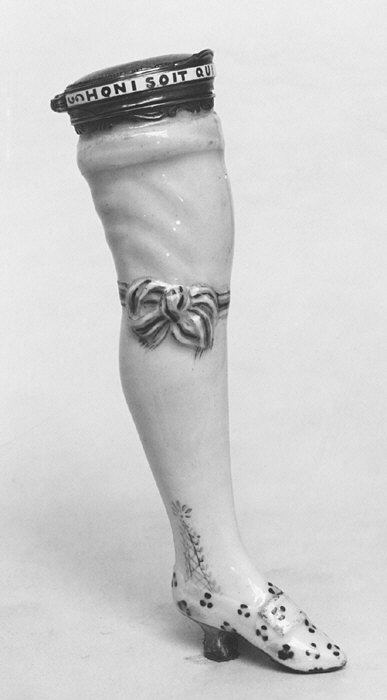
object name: needle case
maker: meissen manufactory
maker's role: manufactory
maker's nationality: german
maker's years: 1710-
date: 1701-1800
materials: gold, porcelain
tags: legs